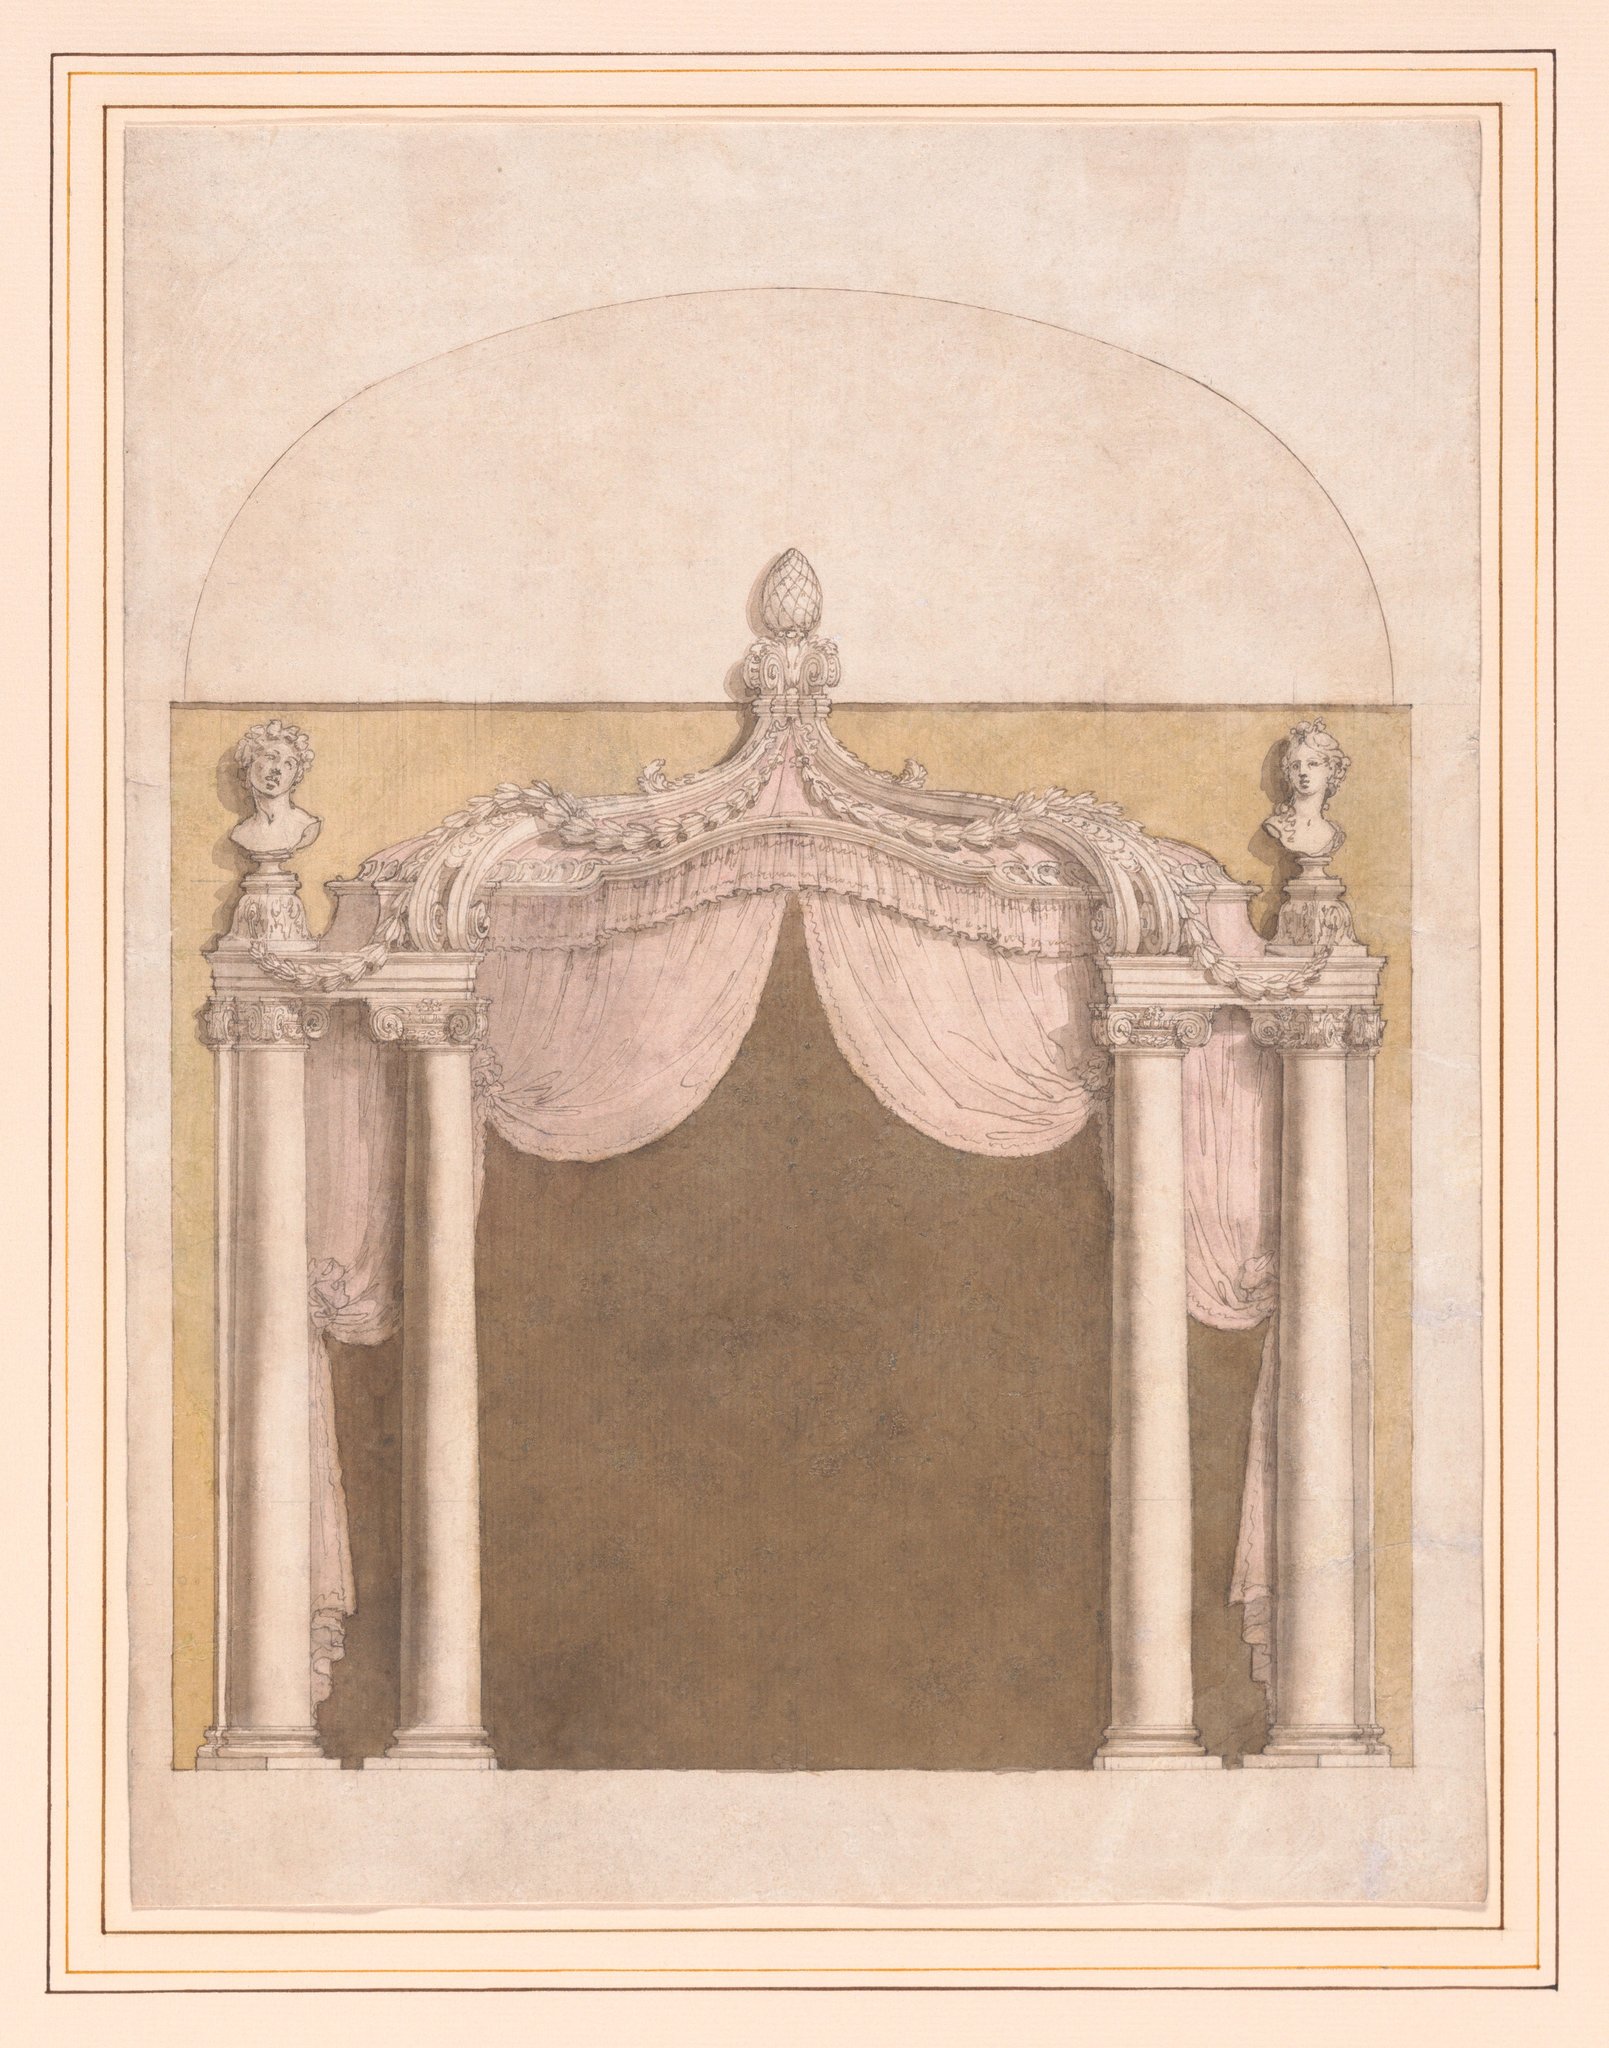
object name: drawing ornament architecture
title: Design for an Alcove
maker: giuseppe valeriani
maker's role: artist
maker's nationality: italian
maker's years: 1708-1761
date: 1740-1760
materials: ink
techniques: pen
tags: architecture